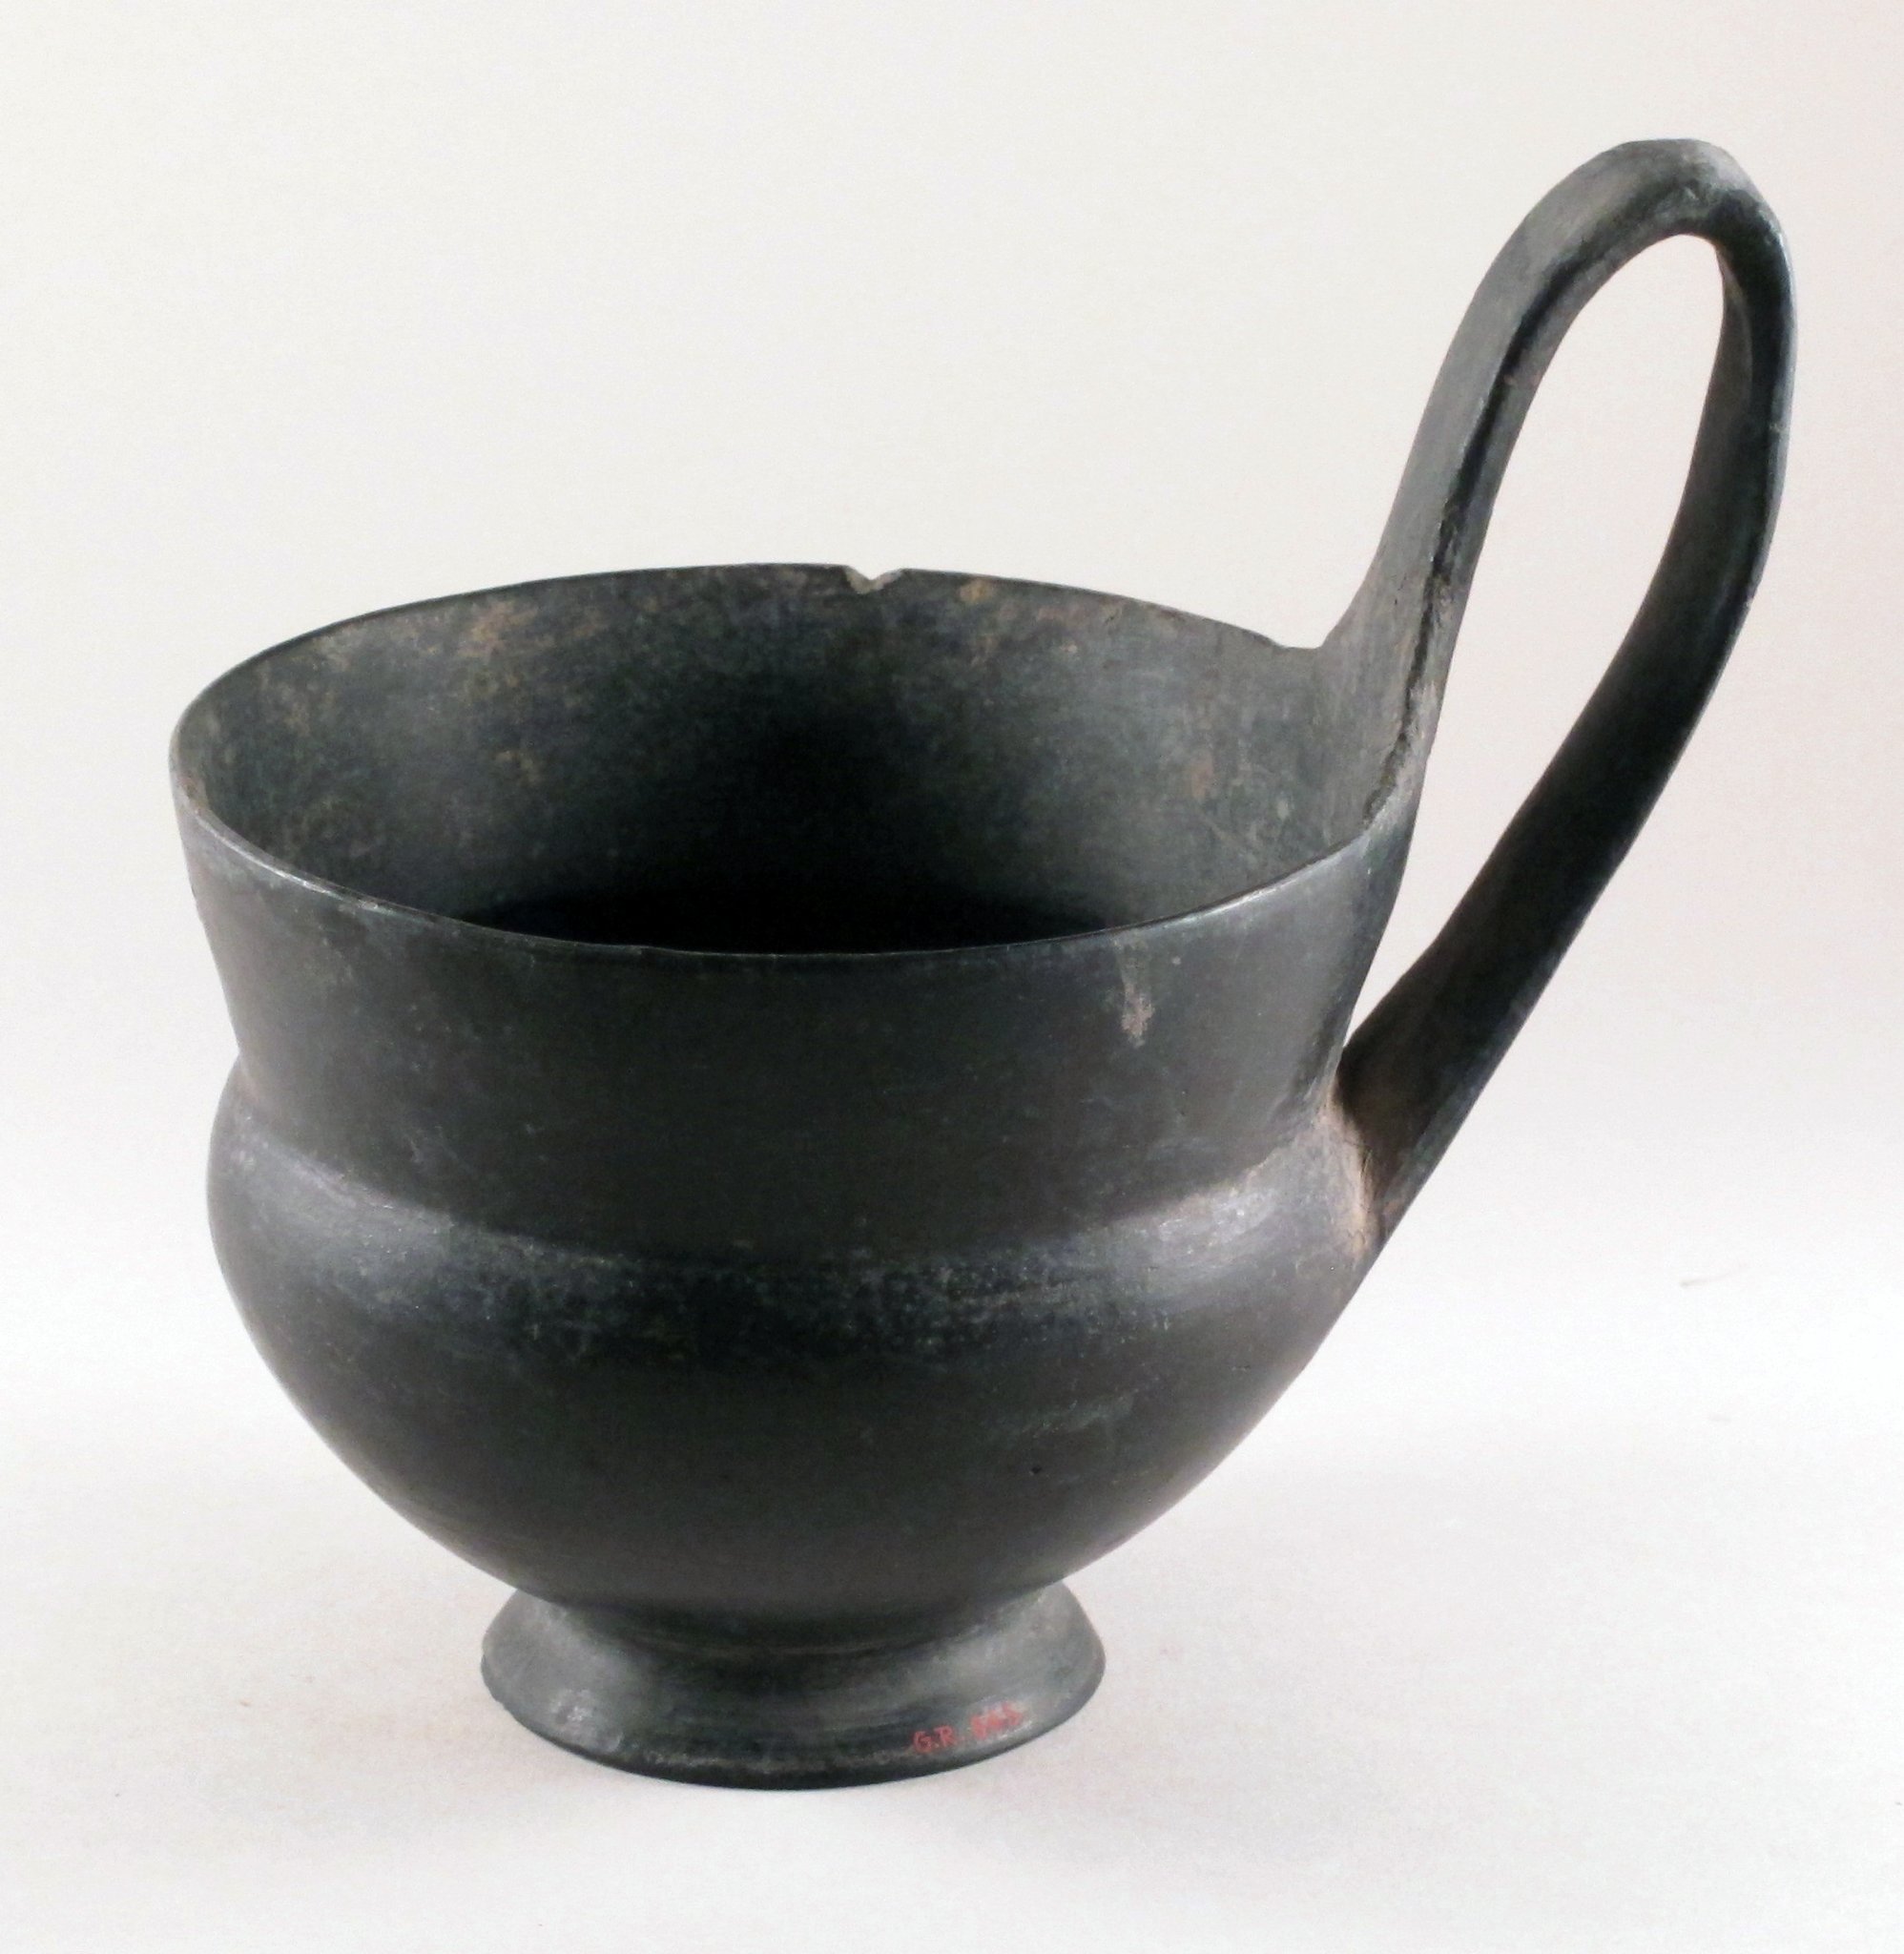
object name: cup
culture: etruscan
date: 600-551 BCE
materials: terracotta